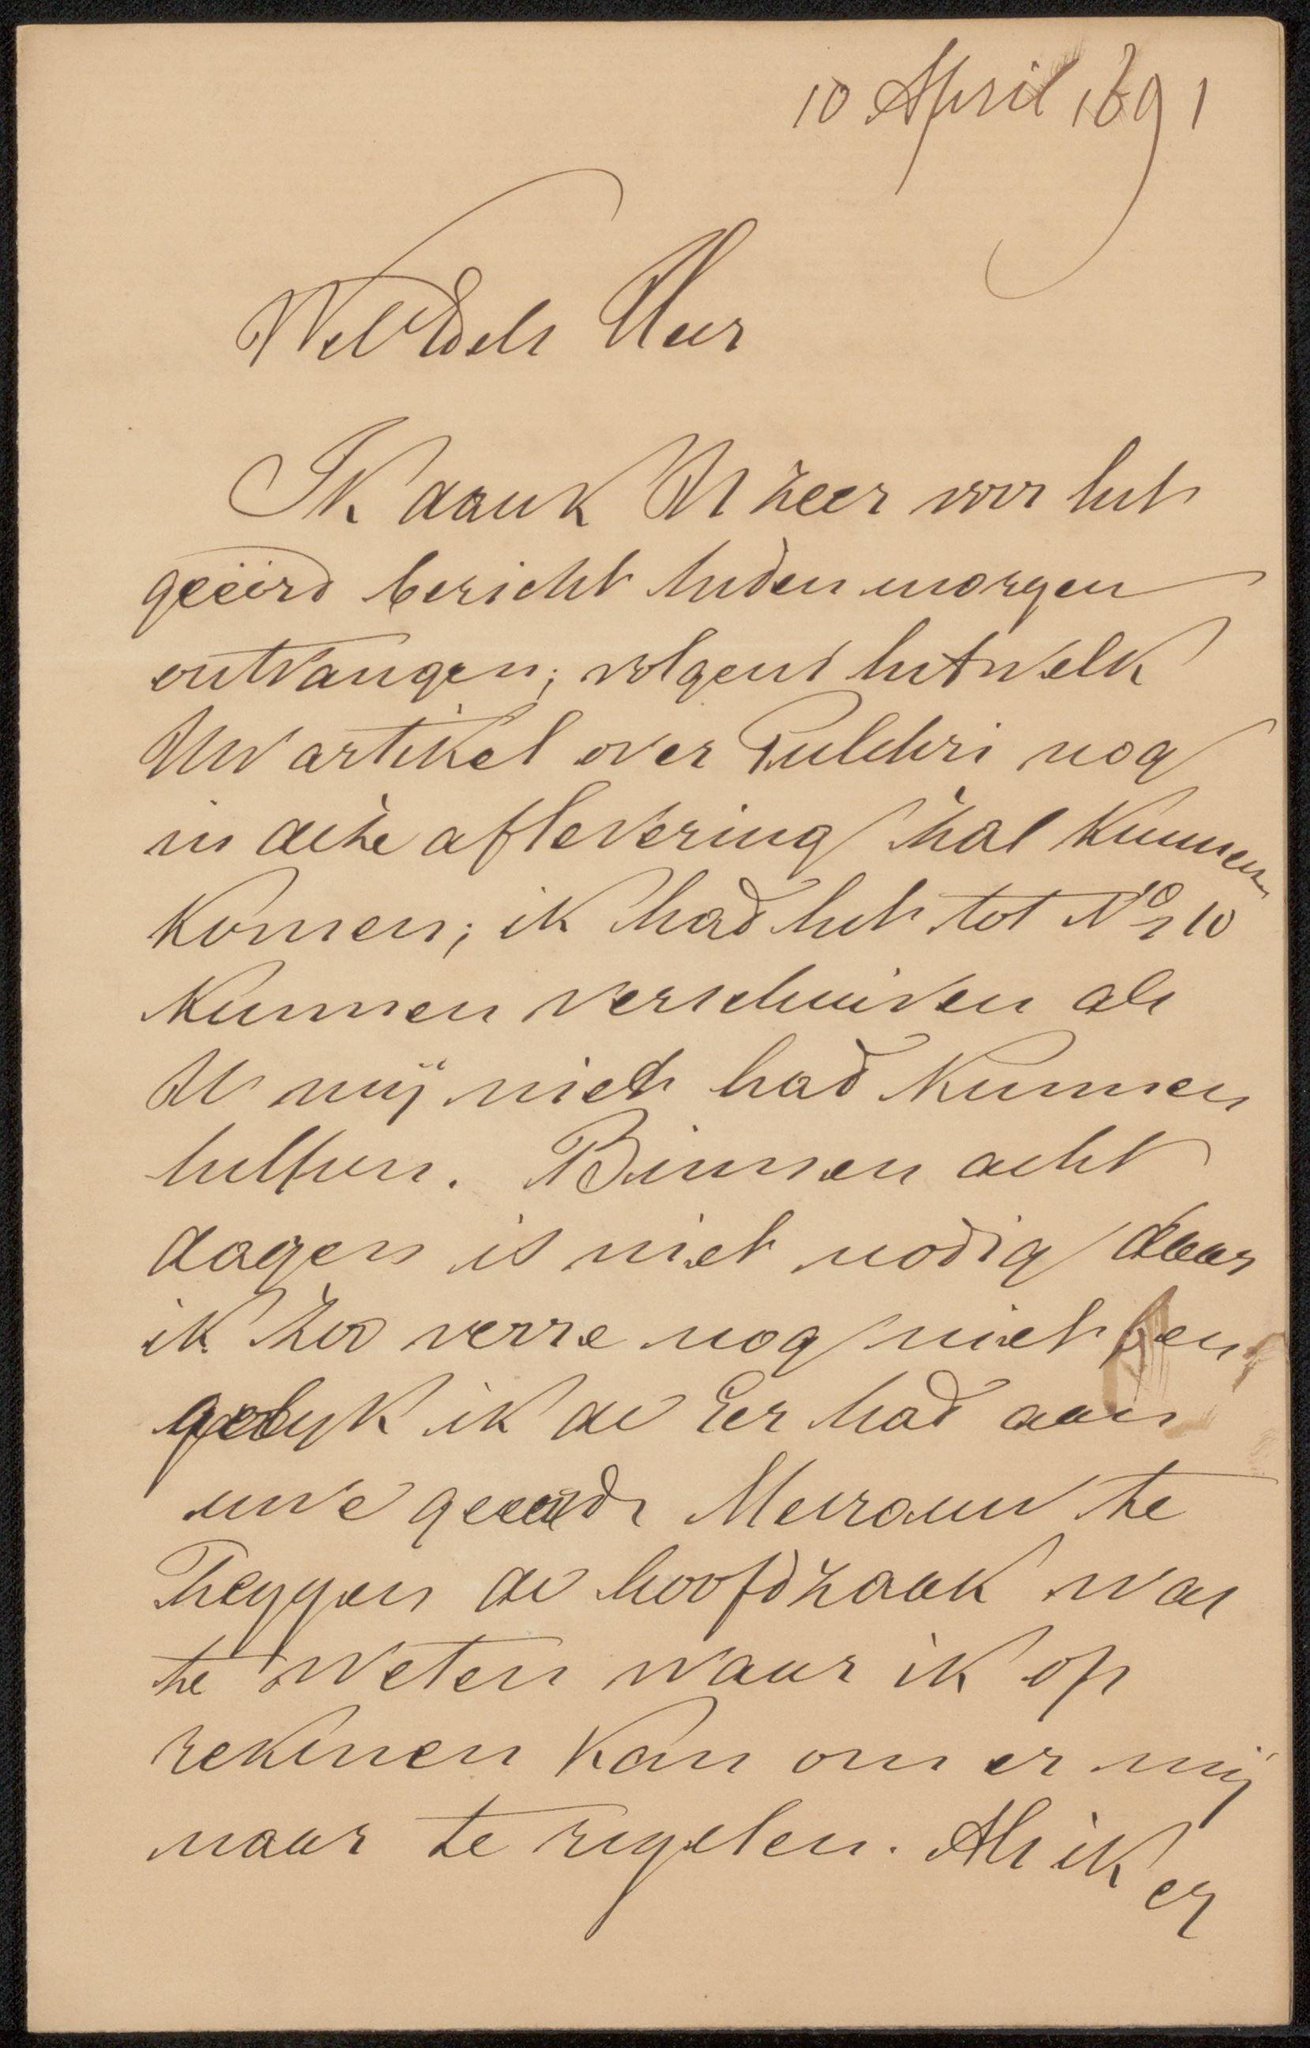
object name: letter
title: Brief aan Philip Zilcken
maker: edouard taurel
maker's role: draughtsman, print maker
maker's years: 1824-1892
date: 1891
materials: ink, paper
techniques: pen, writing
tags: the hague, painter, draughtsman, philip zilcken, printed matter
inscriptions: collector's mark: ‘RPK’